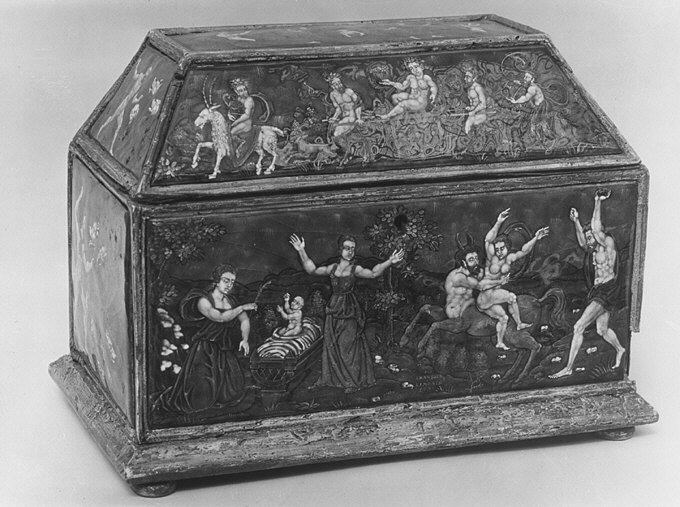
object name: casket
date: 1851-1900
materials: copper, enamel, gilt, wood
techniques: painting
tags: men,women,centaurs